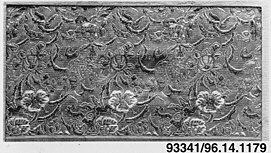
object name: piece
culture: japanese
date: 1701-1900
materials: silk